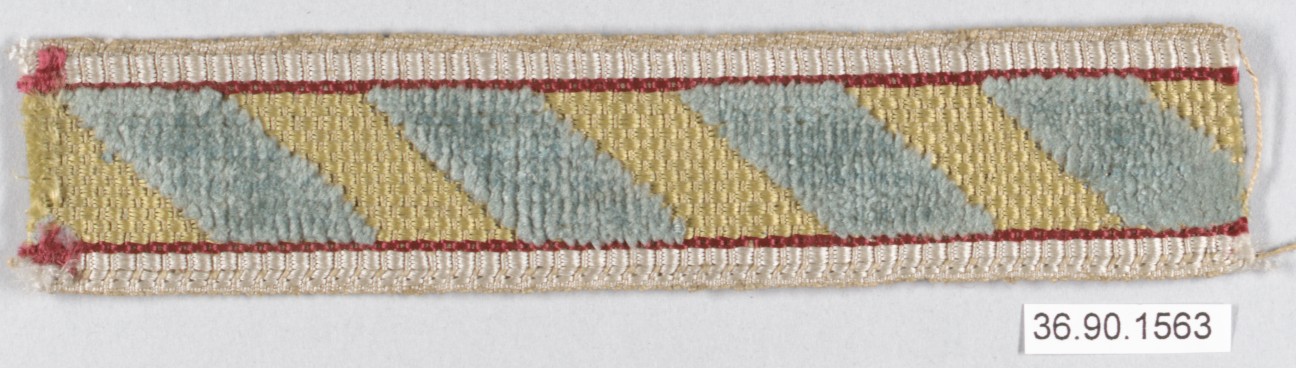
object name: galloon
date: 1701-1900